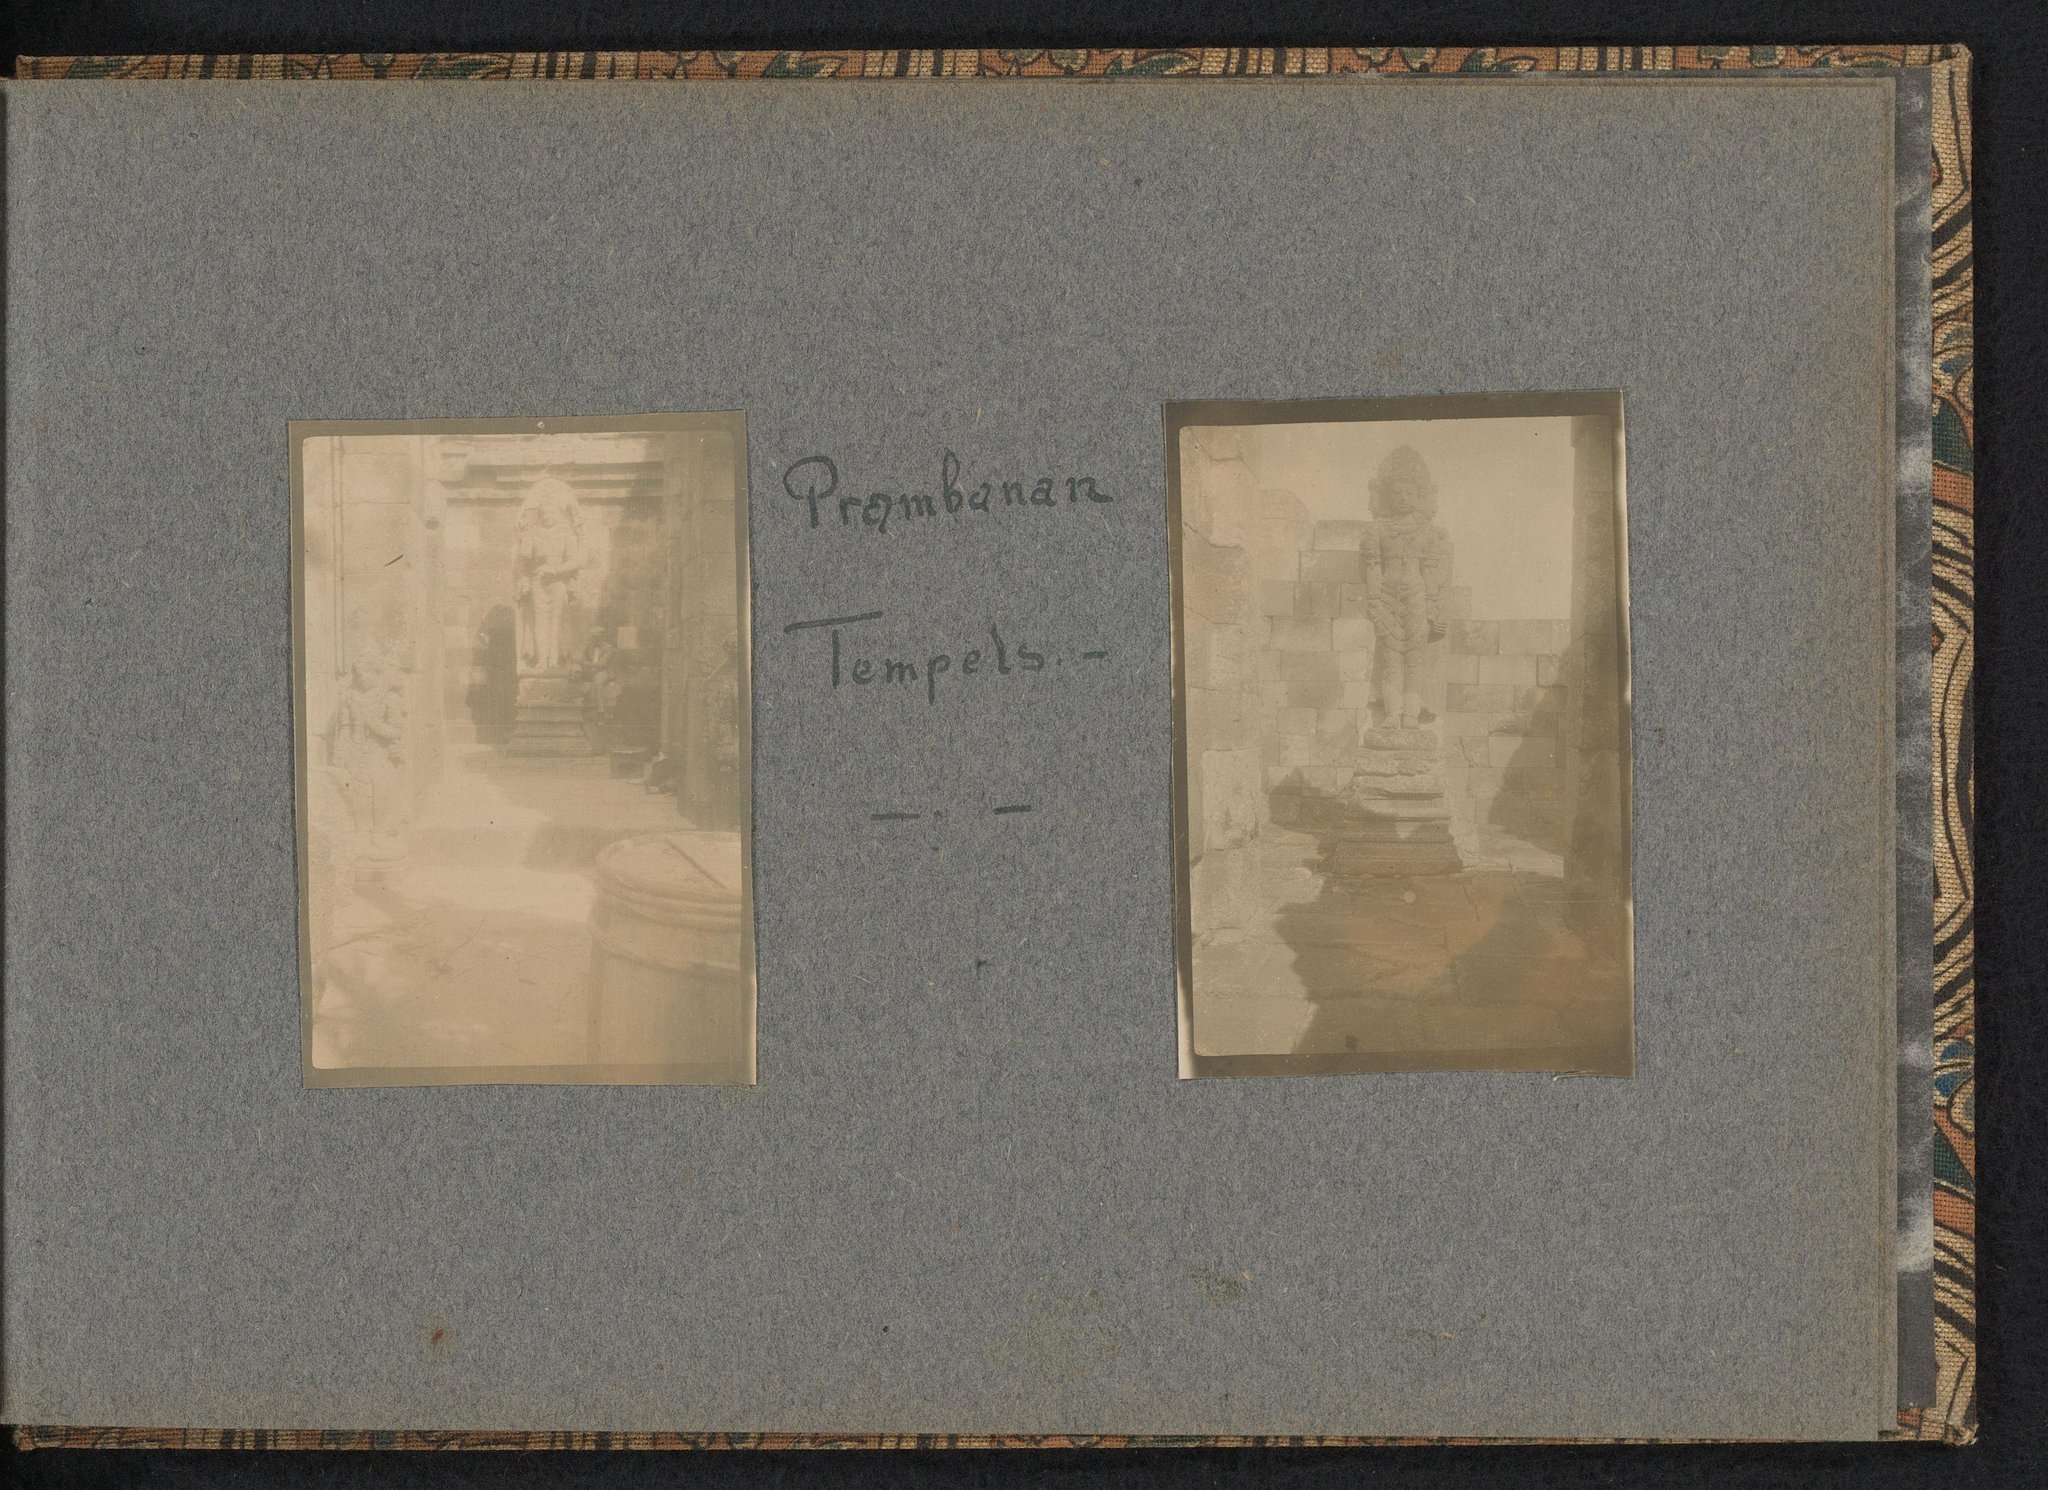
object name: photograph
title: Norbert of Willem van den Berg in de Prambanan in Midden-Java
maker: karel frederik van den berg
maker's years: 1873-1948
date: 1921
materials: paper, cardboard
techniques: gelatin silver print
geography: central java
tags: norbert van den berg (1901-1972), amsterdam, willem jacob van den berg, temple, shrine ~ hinduism, buddhism, jainism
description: Deze foto's zijn onderdeel van een album.